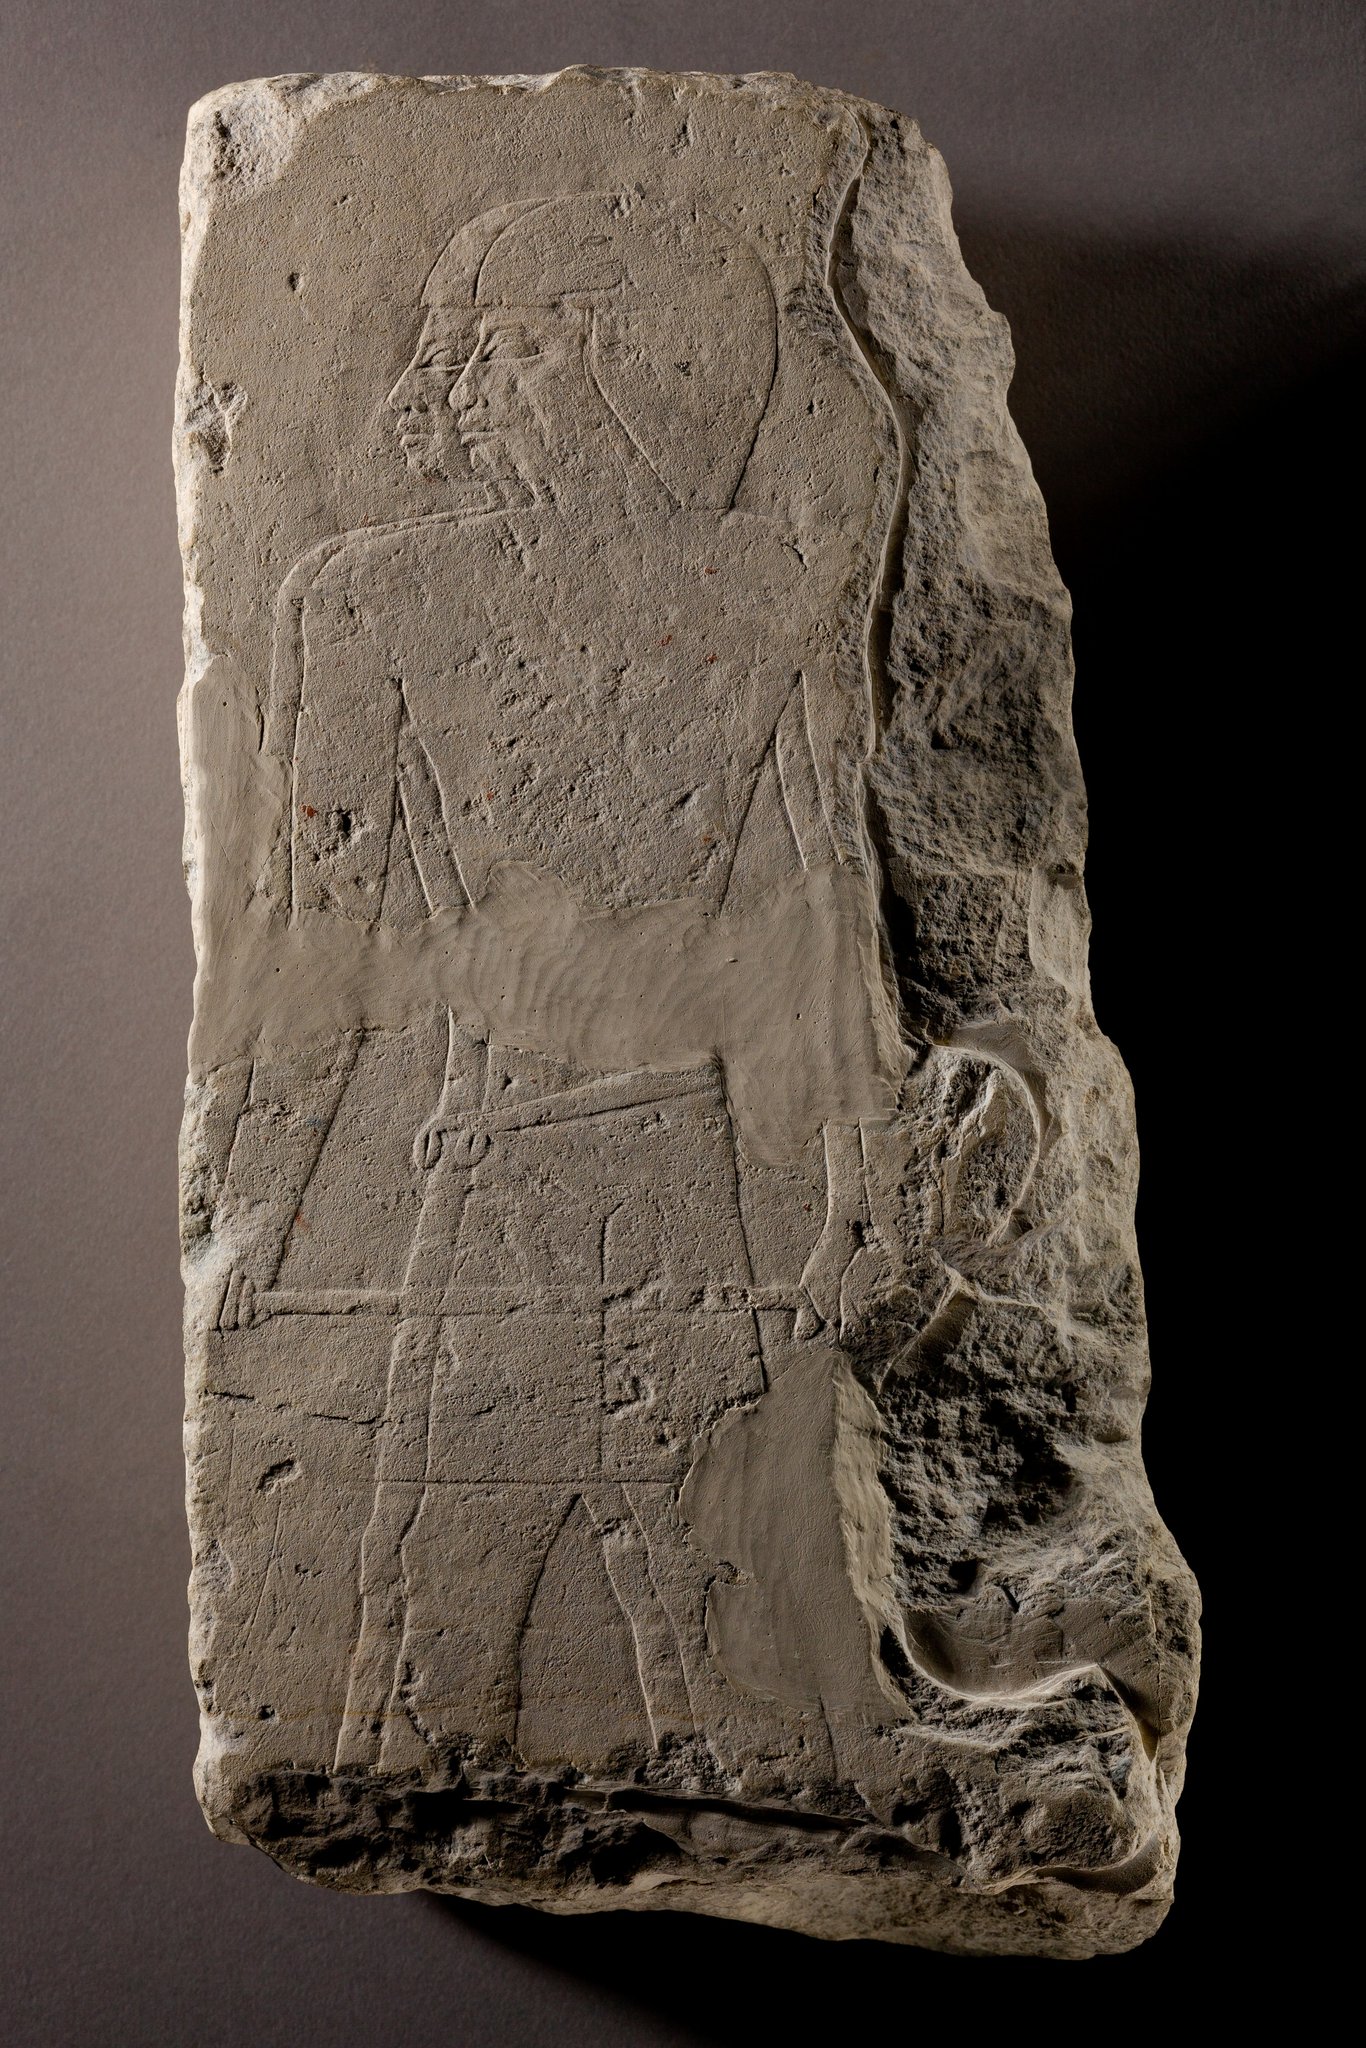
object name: relief fragment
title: Fragment of relief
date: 1981-1640 BCE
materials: limestone, paint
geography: egypt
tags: men